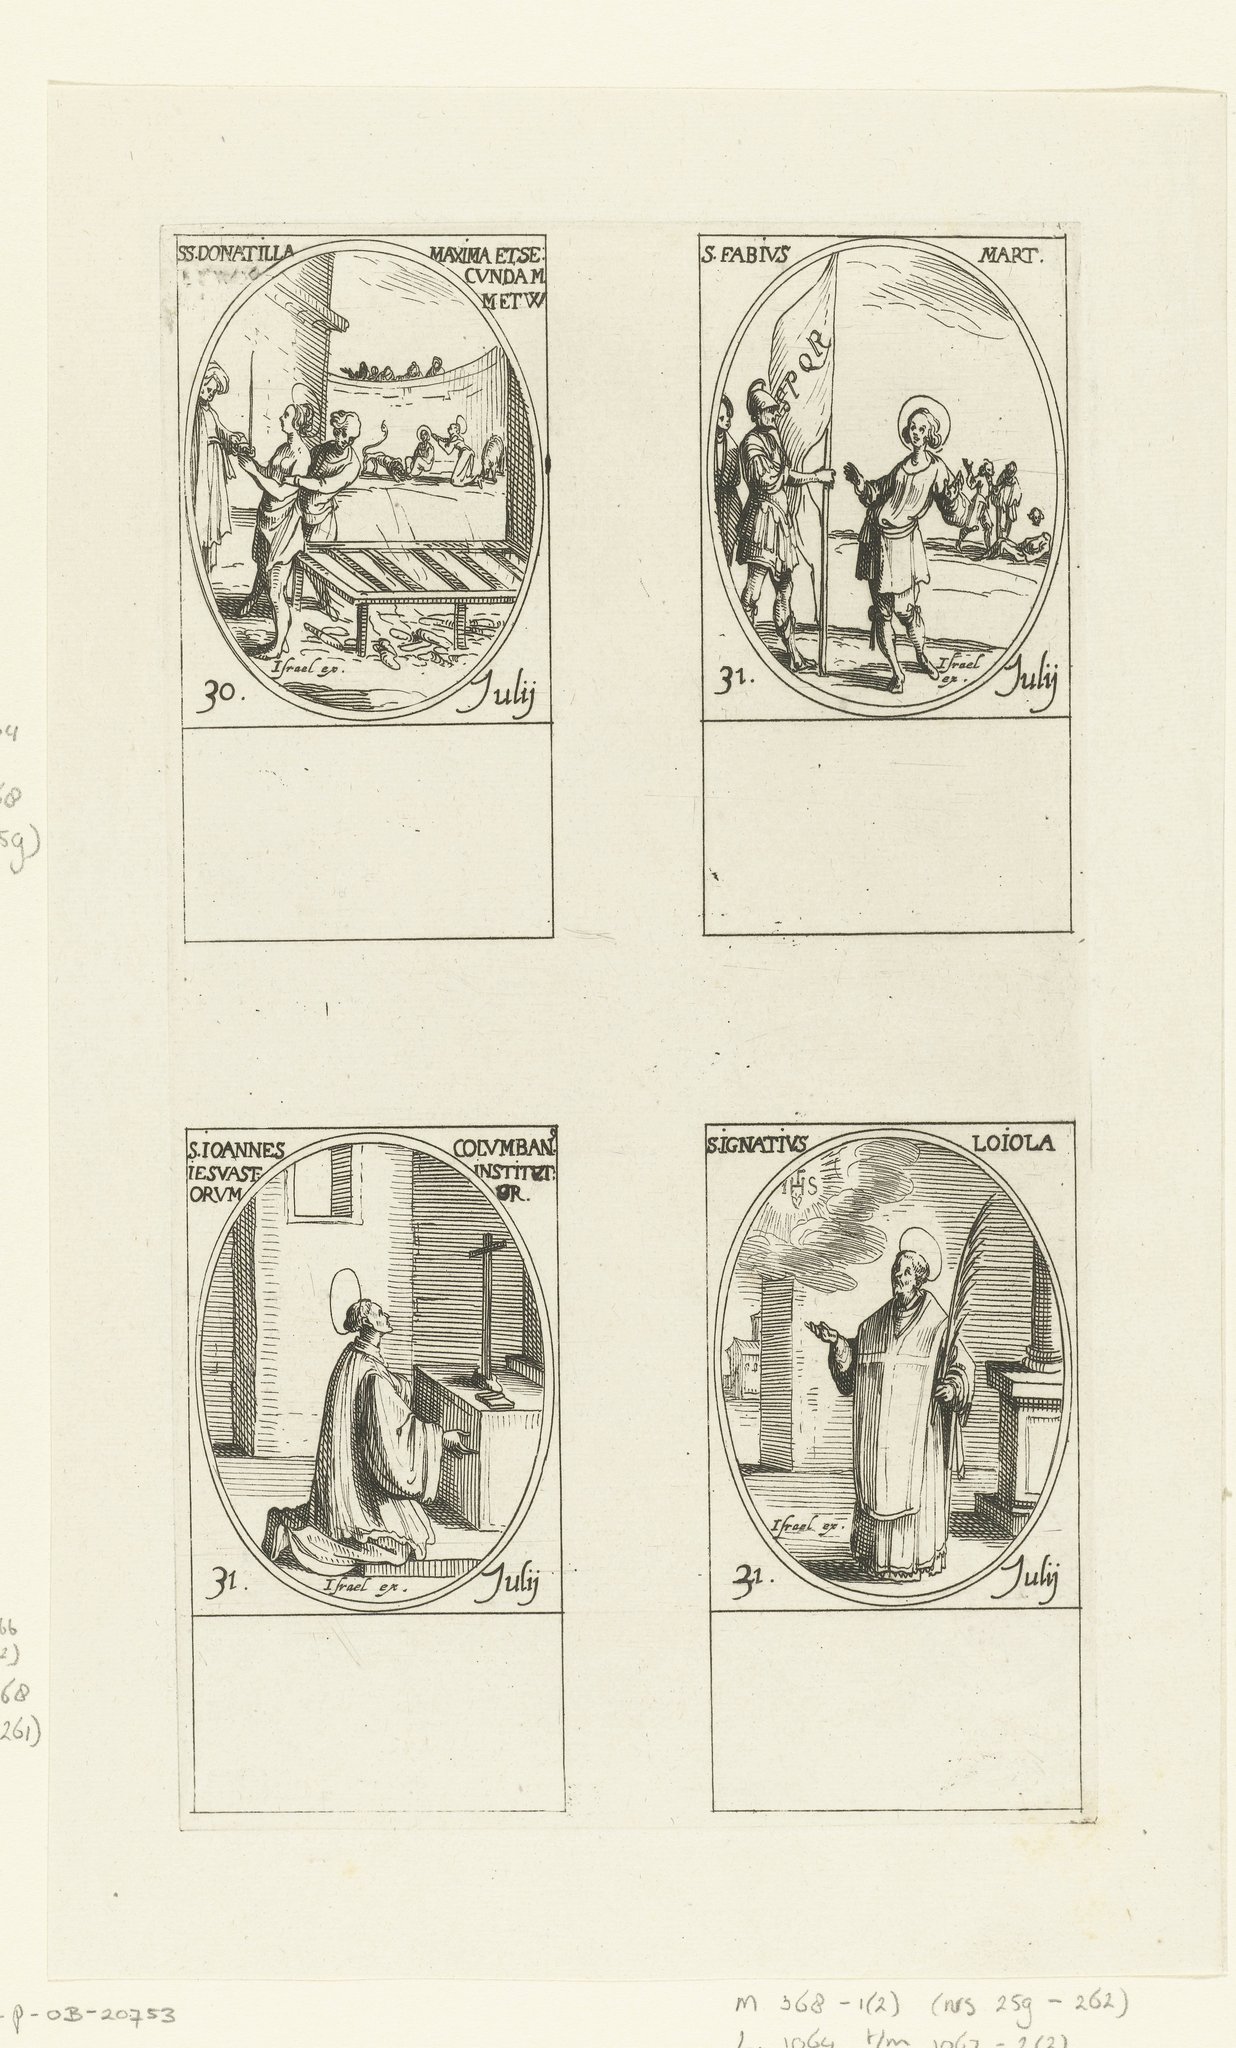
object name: print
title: Heilige Donatilla, Heilige Maxima en Heilige Secunda van Tébourda, Heilige Fabius, Zalige Johannes Colombini, Heilige Ignatius van Loyola (30-31 juli)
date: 1632-1636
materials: paper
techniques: etching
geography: nancy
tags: the founder of the jesuit order, ignatius of loyola; possible attributes: book (with 'ad majorem dei gloriam'), demon, dragon under feet, flames, flaming heart, globe, ihs monogram, skull (with crown), tears in eyes, torch, male saints (with name), female saints (with name)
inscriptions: collector's mark: Lugt 240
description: Blad met vier ovale voorstellingen, elk met opschrift en datum in het Latijn: linksboven de Heilige Donatilla, de Heilige Maxima en de Heilige Secunda worden aan allerlei martelingen blootgesteld, rechtsboven de Heilige Fabius tegenover een Romeins soldaat met een vaandel, linksonder de Zalige Johannes Colomibini geknield voor een altaar, rechtsonder de Heilige Ignatius van Loyola met een palmtak. Deze prent is onderdeel van een serie prenten met voorstellingen van de heiligen en de christelijke feestdagen van het jaar. Er zijn steeds vier scènes van één plaat op één blad gedrukt. Inclusief bijbehorend titelblad en frontispice gaat het in totaal om 124 platen (490 voorstellingen). De drie platen met de laatste 12 scènes (de veranderlijke christelijke feestdagen) zijn in de derde staat versneden tot 12 kleine plaatjes, en met een apart titelblad uitgegeven.